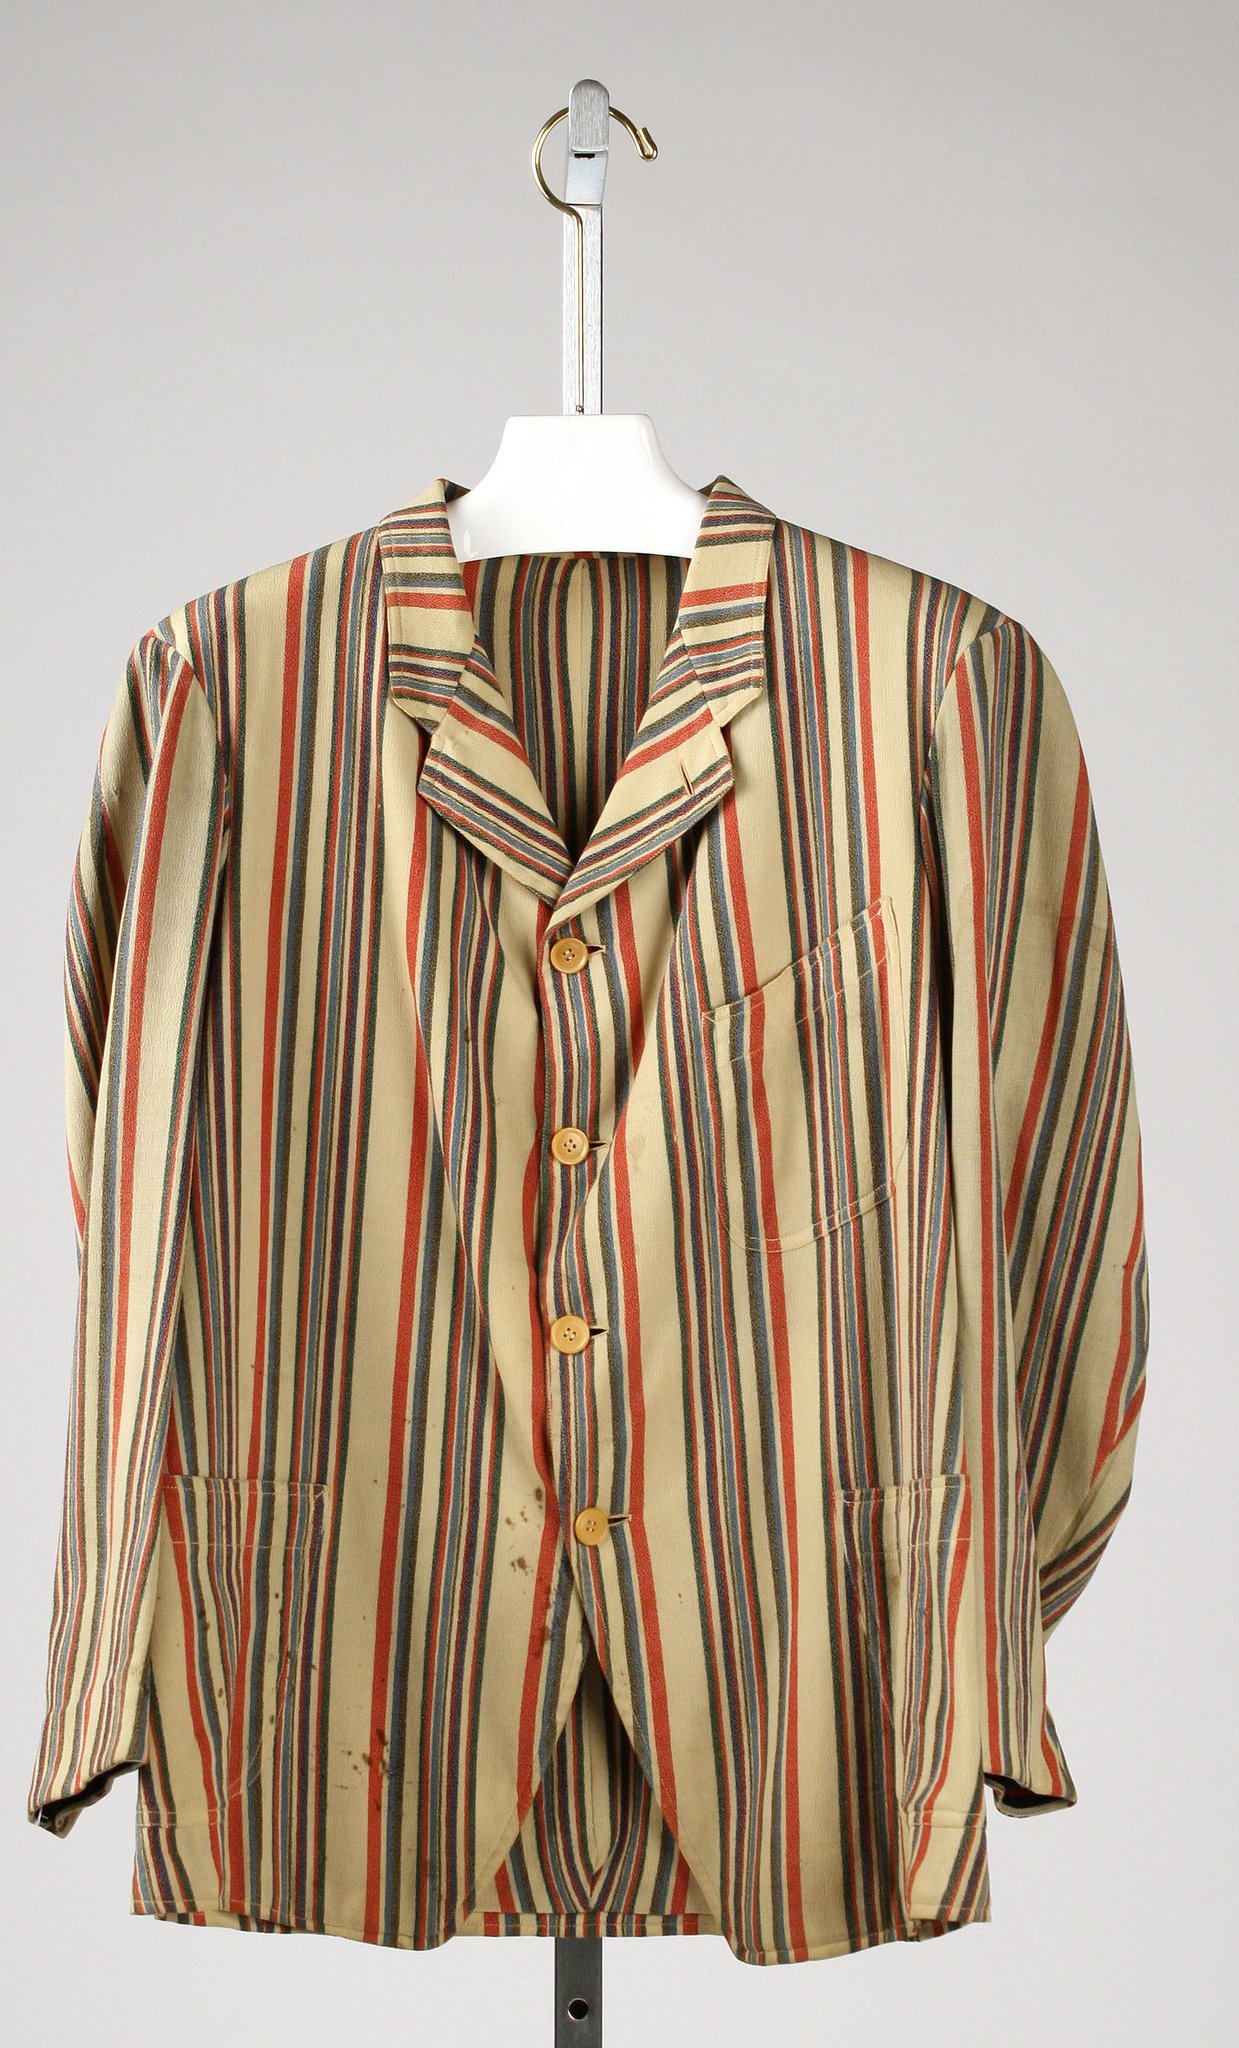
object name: blazer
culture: american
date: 1890-1899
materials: wool